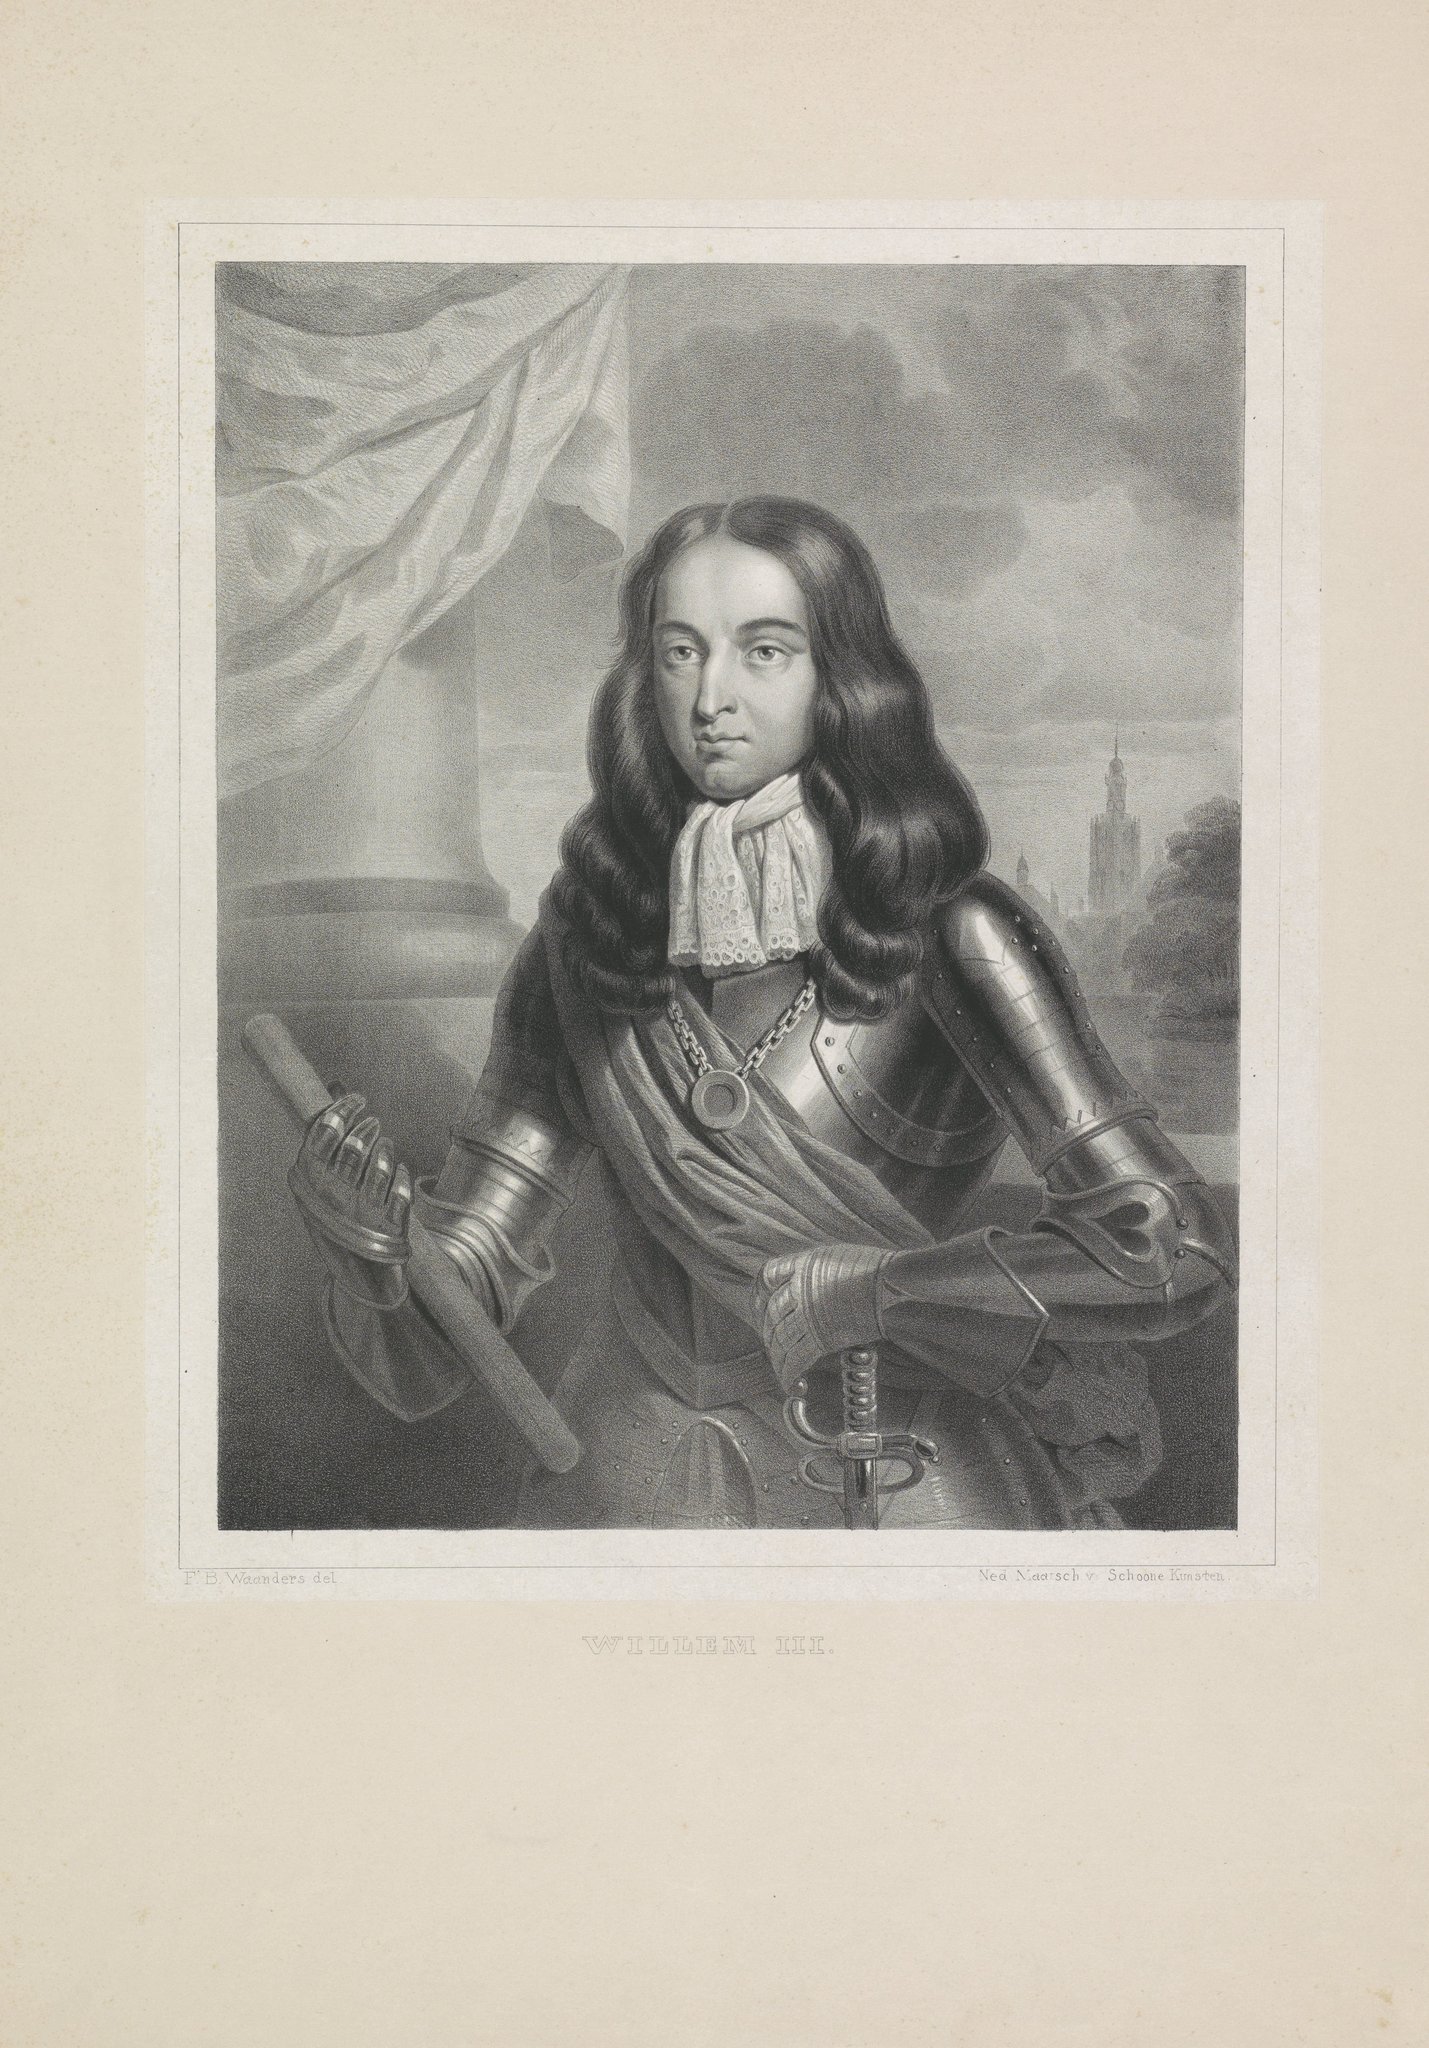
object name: print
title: Portret van Willem III, prins van Oranje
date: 1840-1843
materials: paper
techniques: lithograph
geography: the hague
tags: the hague, william iii (prince of orange and king of england, scotland, and ireland)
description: De hier vermelde titel verwijst naar de hoogst verkregen titel van de geportretteerde, niet per se naar de titel die de geportretteerde op deze voorstelling draagt.